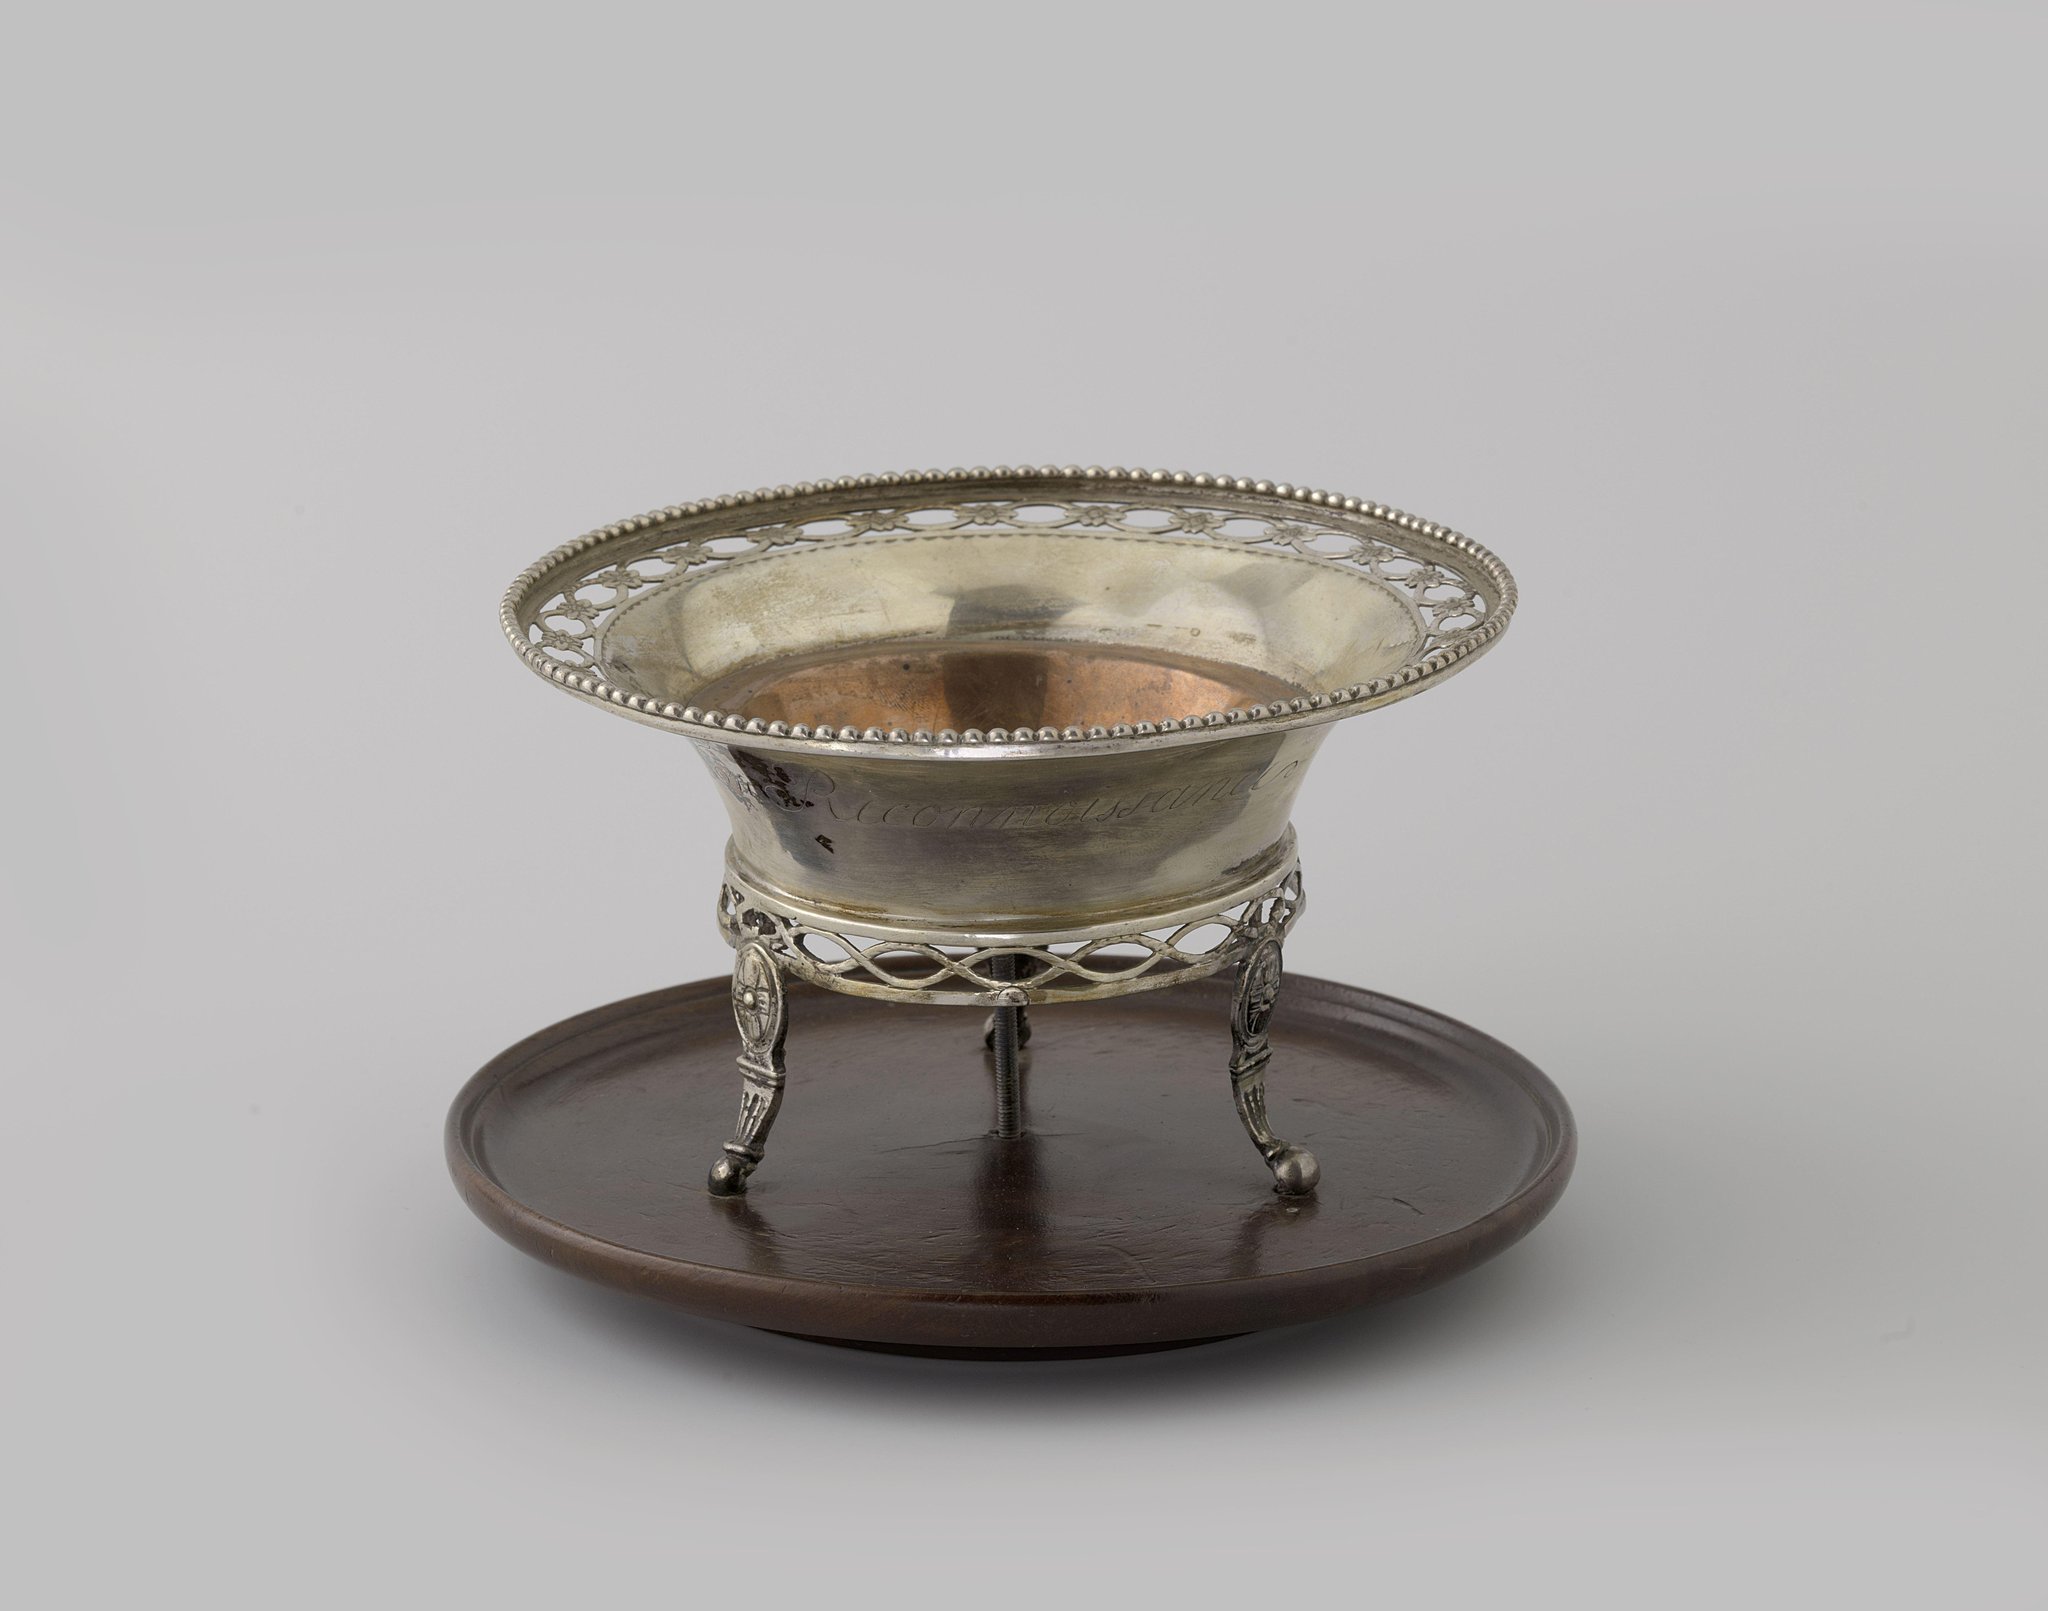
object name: komfoor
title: Komfoor van zilver op een houten blad. Rond vat op drie poten en uitgebogen rand. Langs de onderkant versierd met een opengewerkte slinger met rozetten.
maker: Anonymous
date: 1785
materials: copper, silver, wood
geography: netherlands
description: Komfoor van zilver op drie pootjes, met een koperen binnenbak en op een houten blad. Rond met een uitgebogen rand. Langs de onderkant een opengewerkte slinger met rozetten.